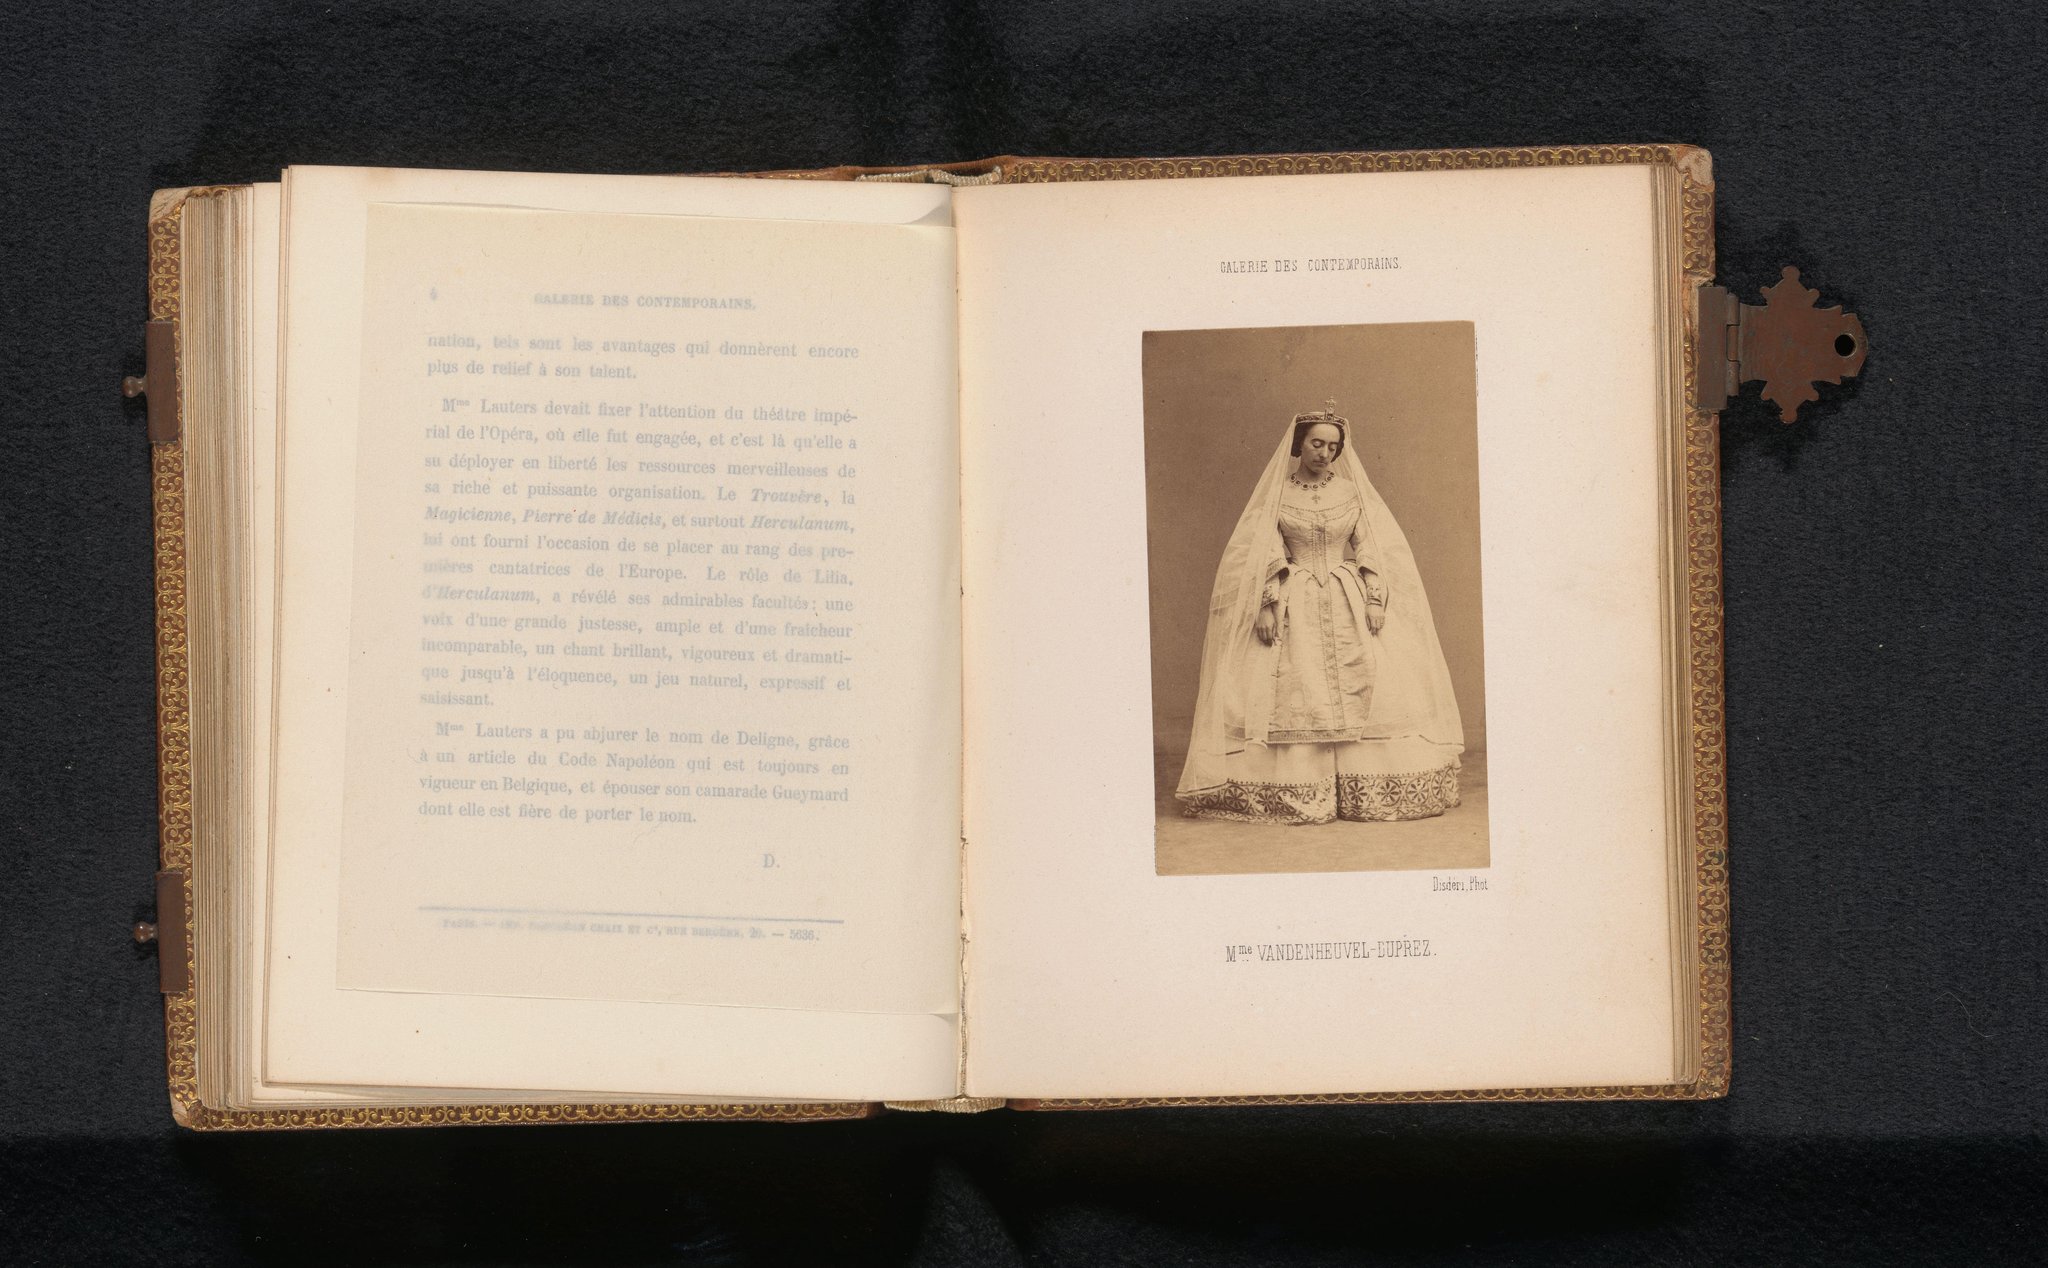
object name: photograph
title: Mme Van den Heuvel-Duprez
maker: andré-adolphe-eugène disdéri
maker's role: fotograaf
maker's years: 1819-1889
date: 1857-1862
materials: photographic support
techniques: albumen print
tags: adult woman, historical persons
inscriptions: inscription: ‘Galerie des Contemporains’